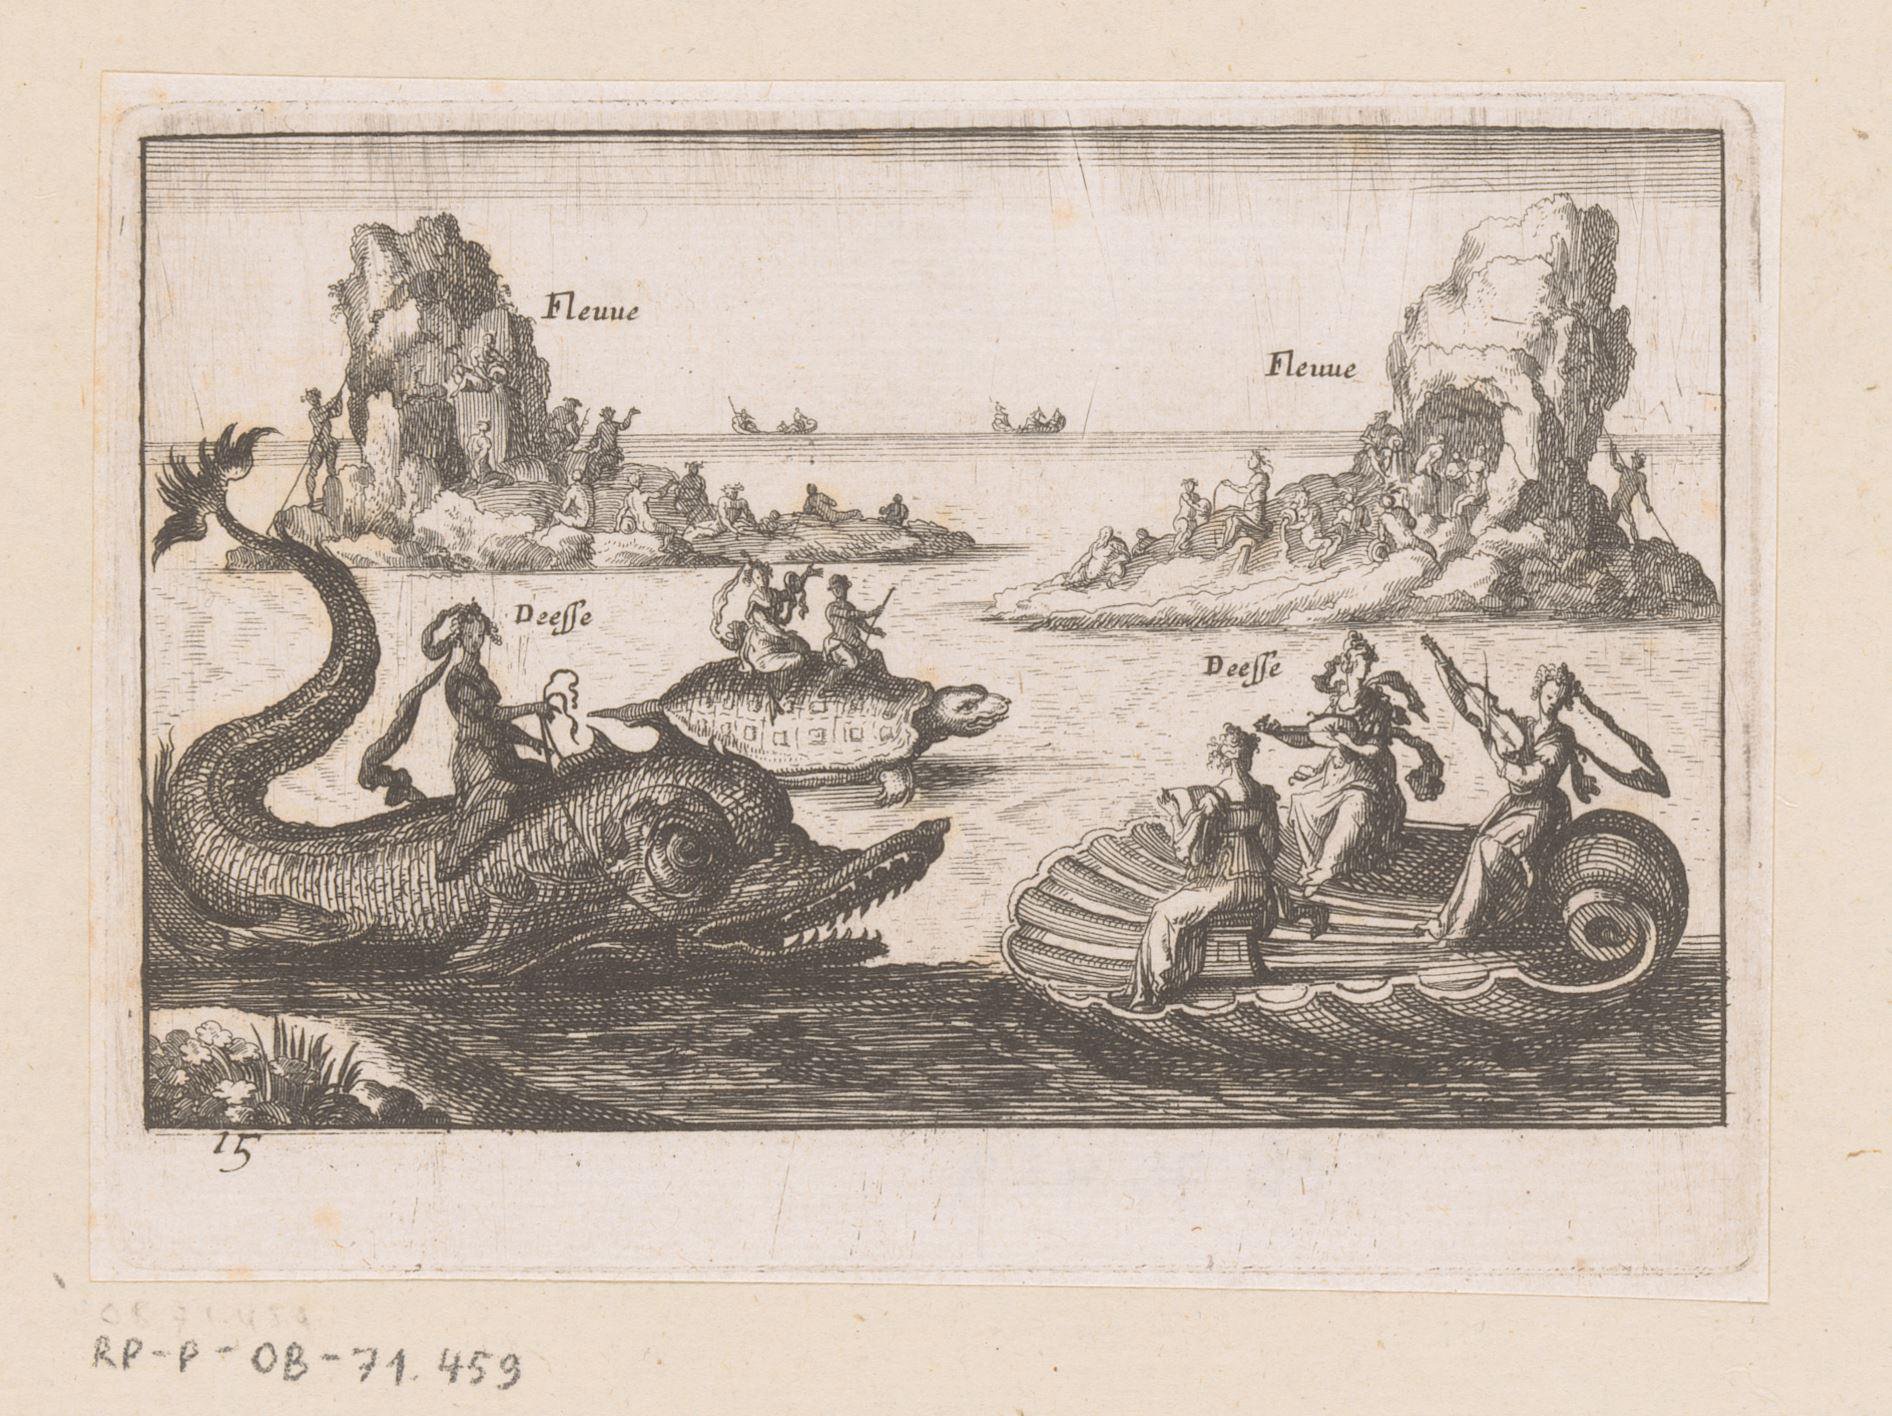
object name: print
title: Argonautenschepen voor de strijd op de Arno tijdens het huwelijksfeest van Cosimo II de' Medici te Florence in 1608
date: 1635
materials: paper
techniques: etching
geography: paris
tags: tortoises, turtles, swimming mammals: dolphin, scallop, shell ~ ornament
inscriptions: collector's mark: Lugt 240